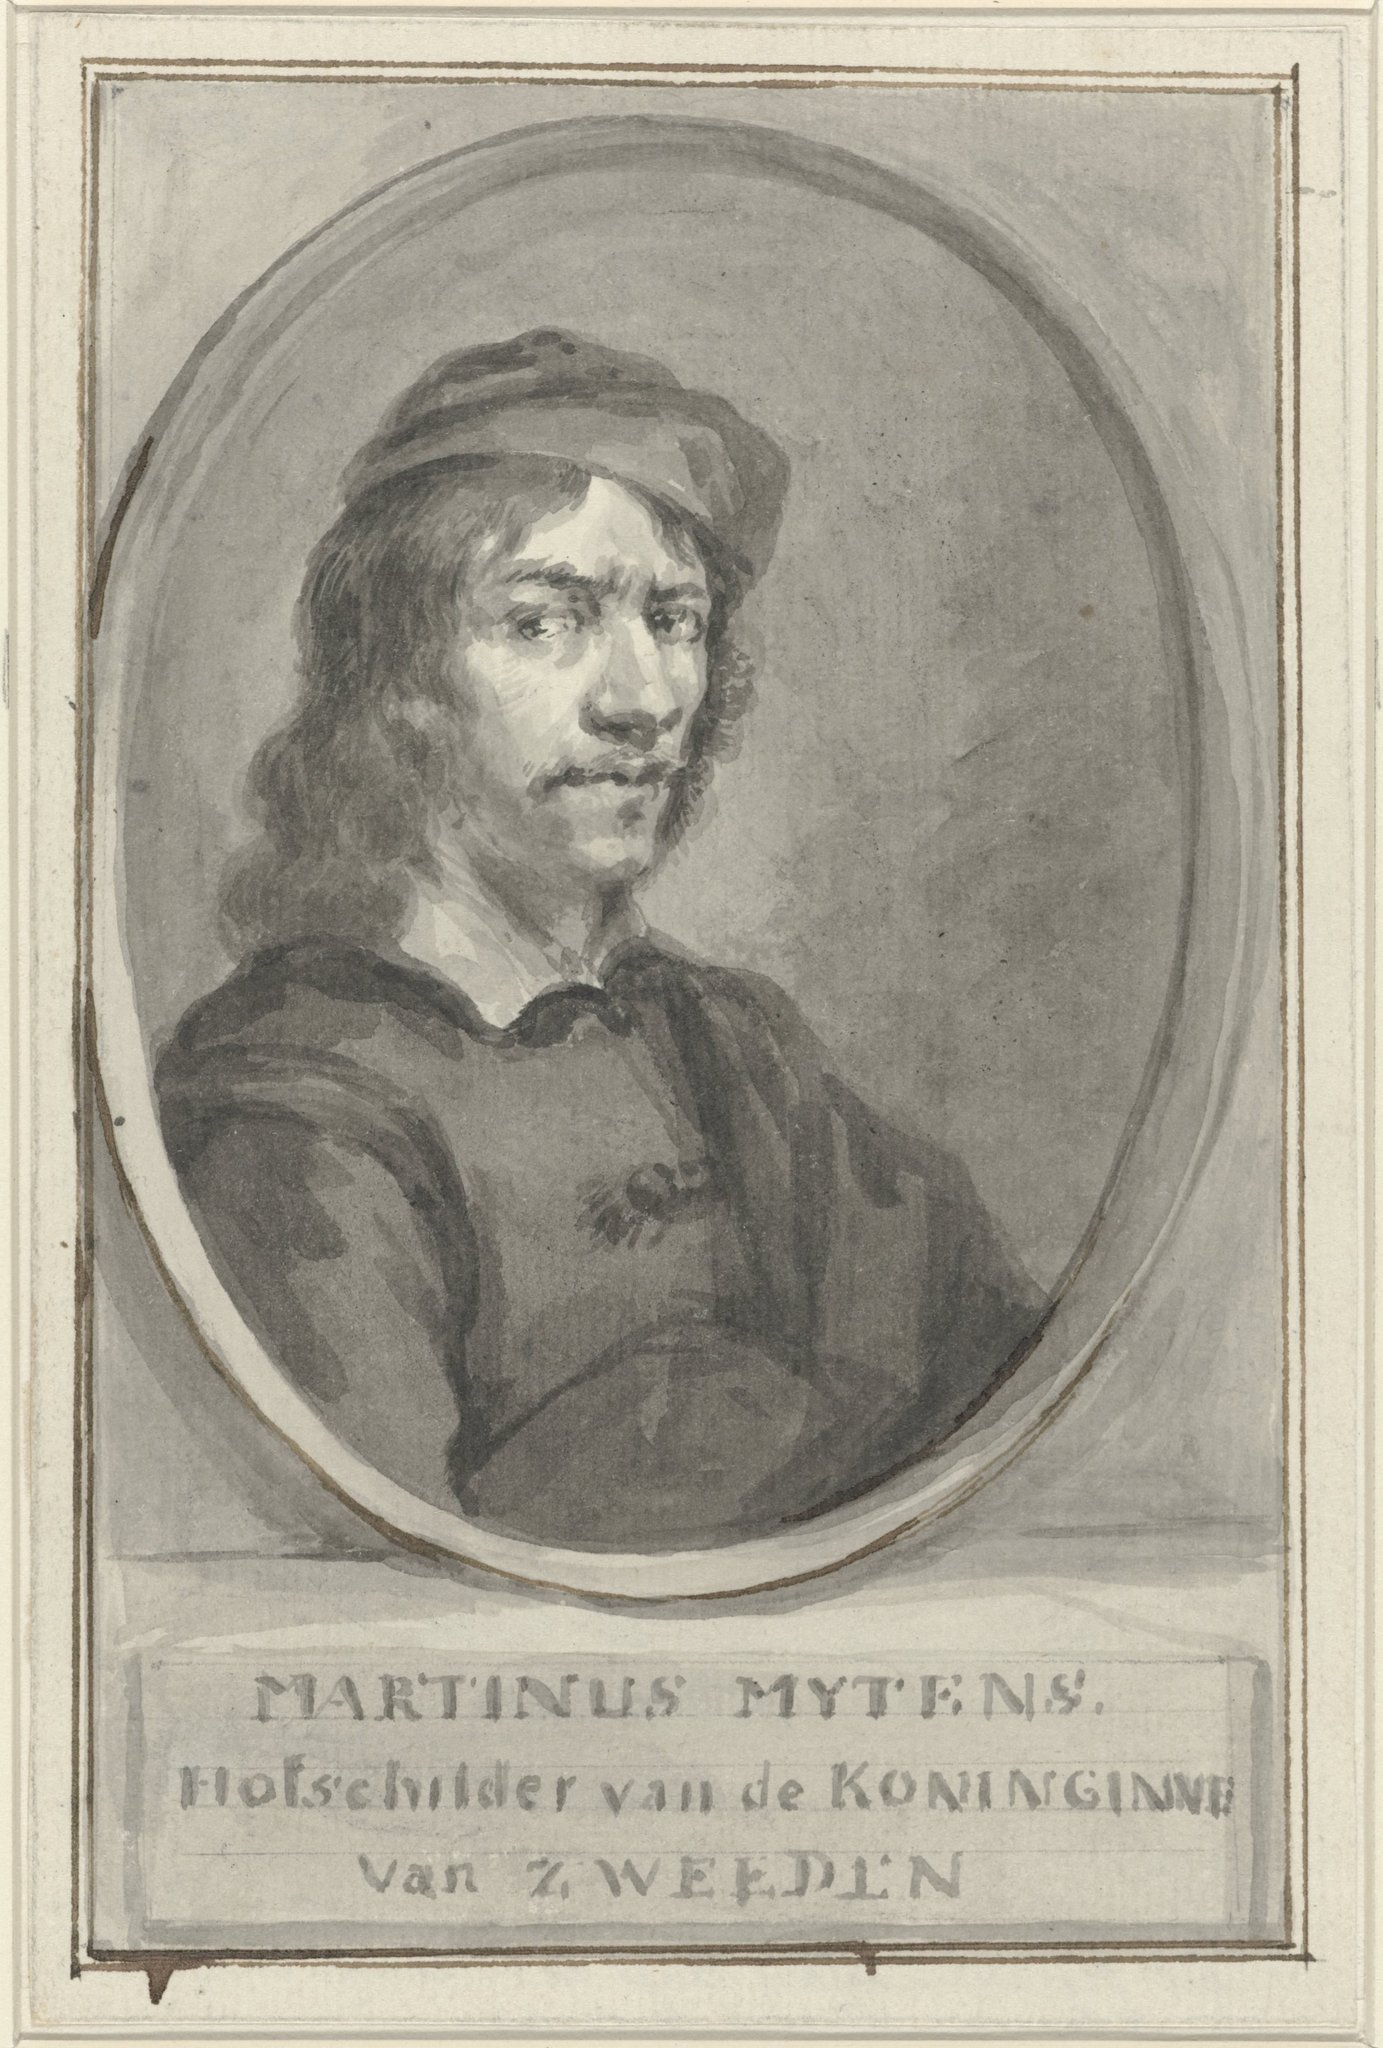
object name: drawing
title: Portret van Martinus Mytens de Oude / Martin Mytens (der Ältere)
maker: aert schouman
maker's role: draughtsman, painter, print maker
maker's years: 1710-1792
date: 1792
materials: ink, paper, pencil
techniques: brush, pen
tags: the hague, painter, print maker, martin mytens (i), historical persons, portrait, self-portrait of painter, portrait, self-portrait of artist